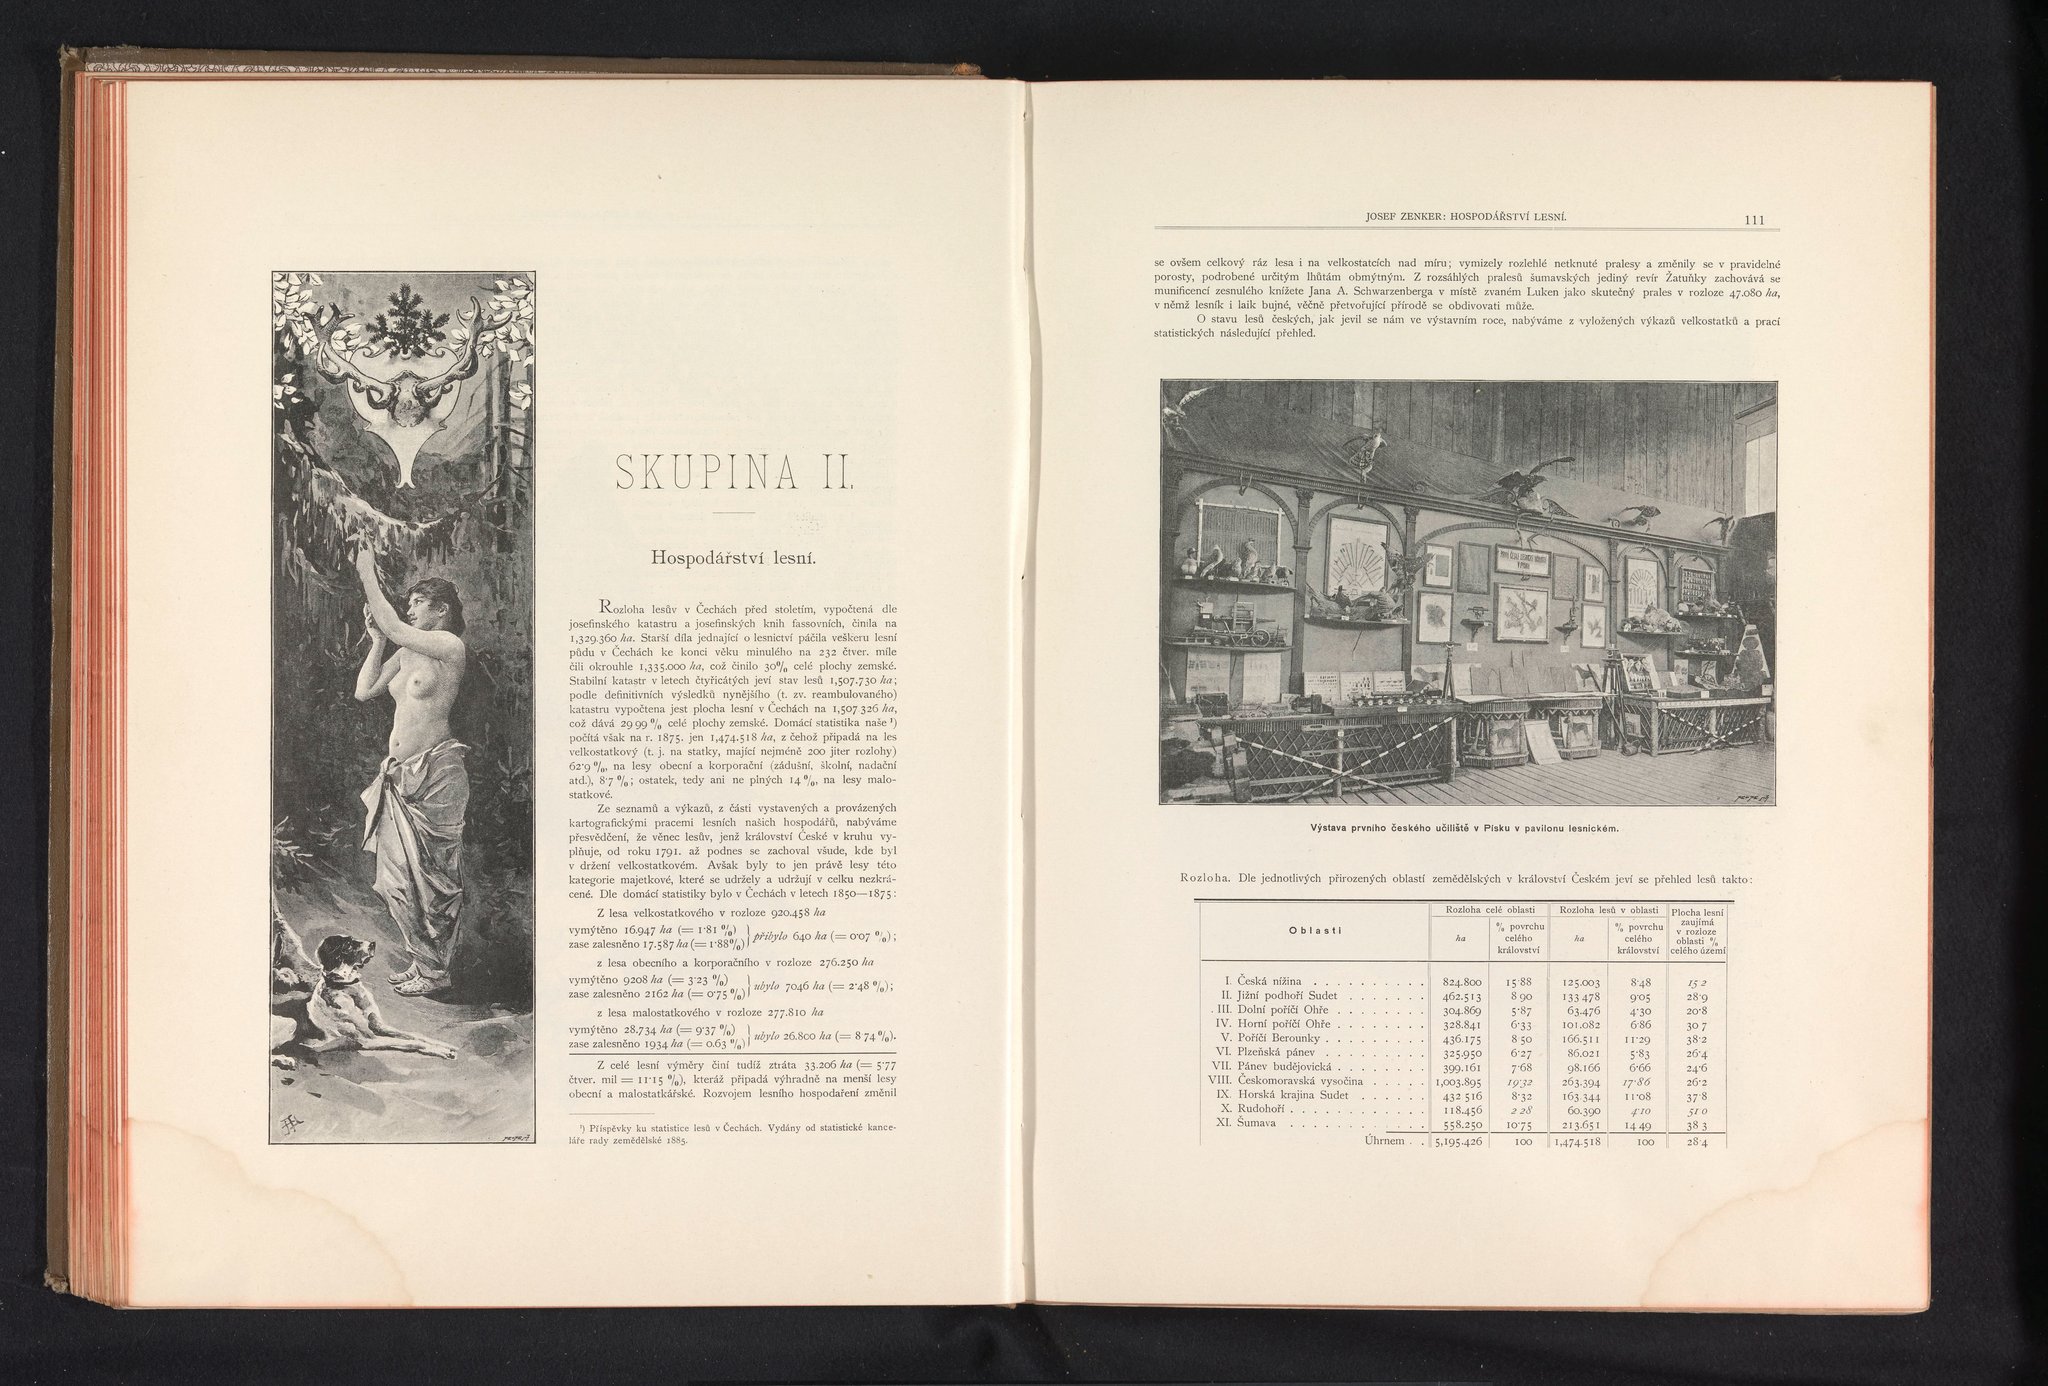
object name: page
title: Fotoreproductie van een tekening, voorstellende een halfnaakte vrouw met een hond in een bos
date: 1891-1895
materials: paper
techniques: autotype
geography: prague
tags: woman (showing herself) undressed, quasi-nude, forest, wood, dog